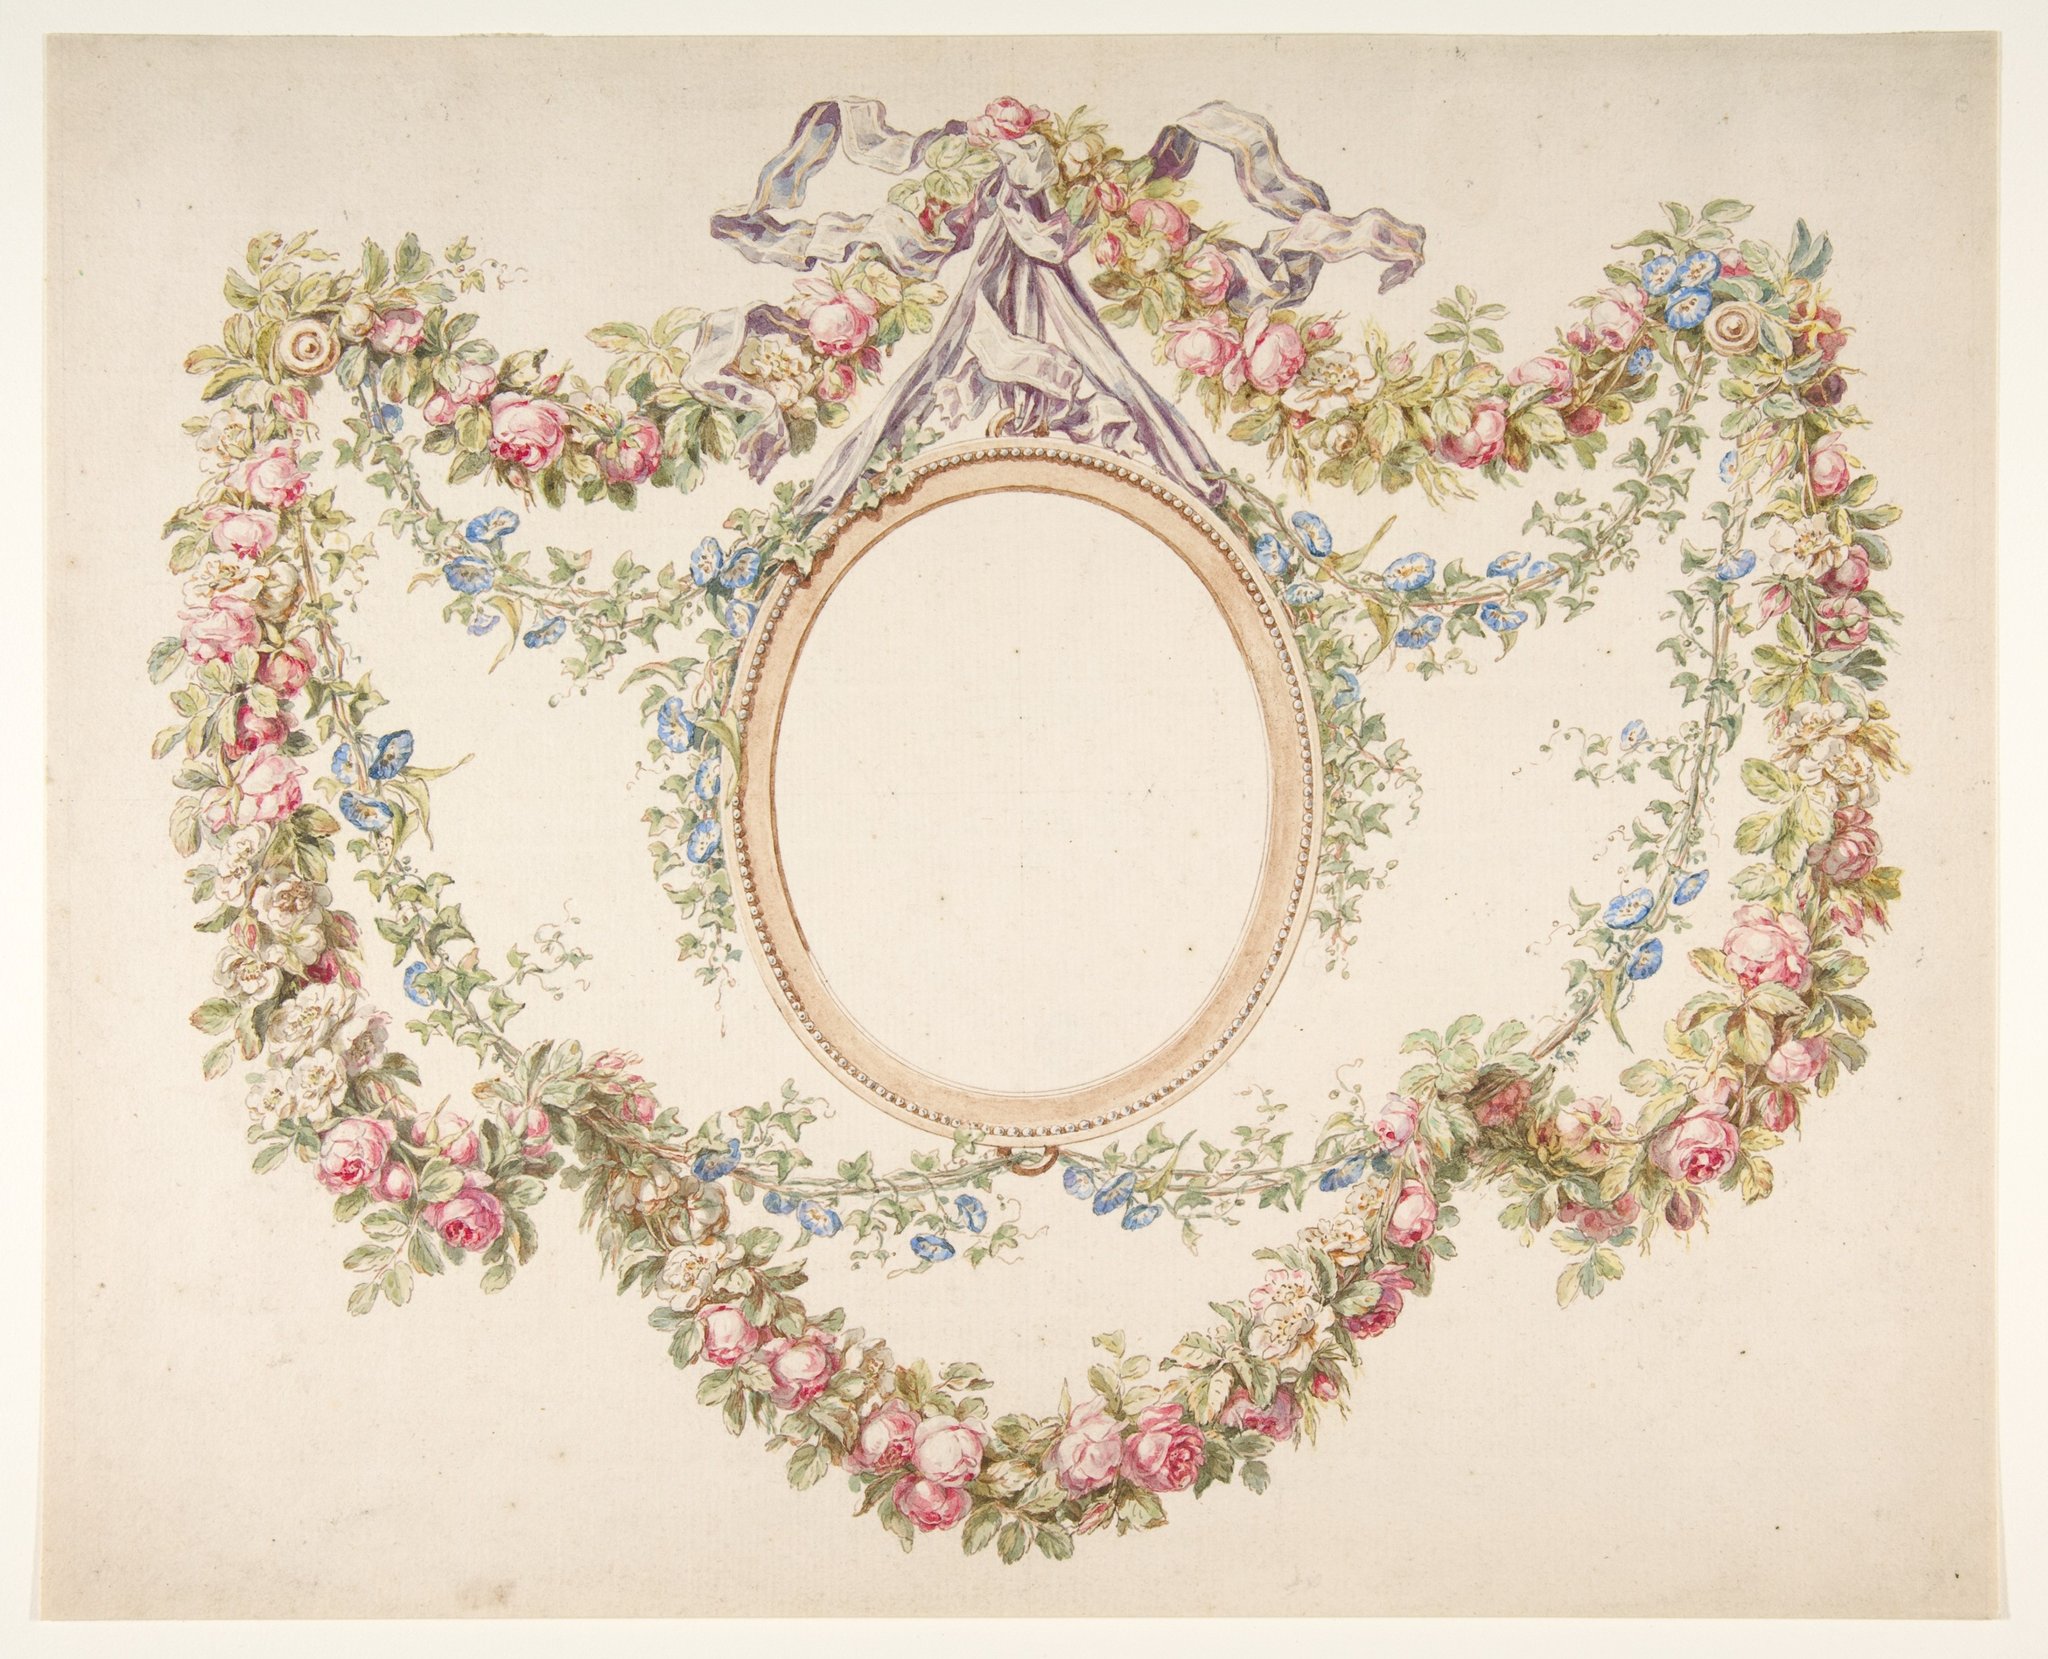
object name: drawing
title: Floral Swags Framing an Empty Oval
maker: jean pillement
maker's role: artist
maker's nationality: french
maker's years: 1728-1808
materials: ink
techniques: brush, pen, wash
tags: garlands,roses